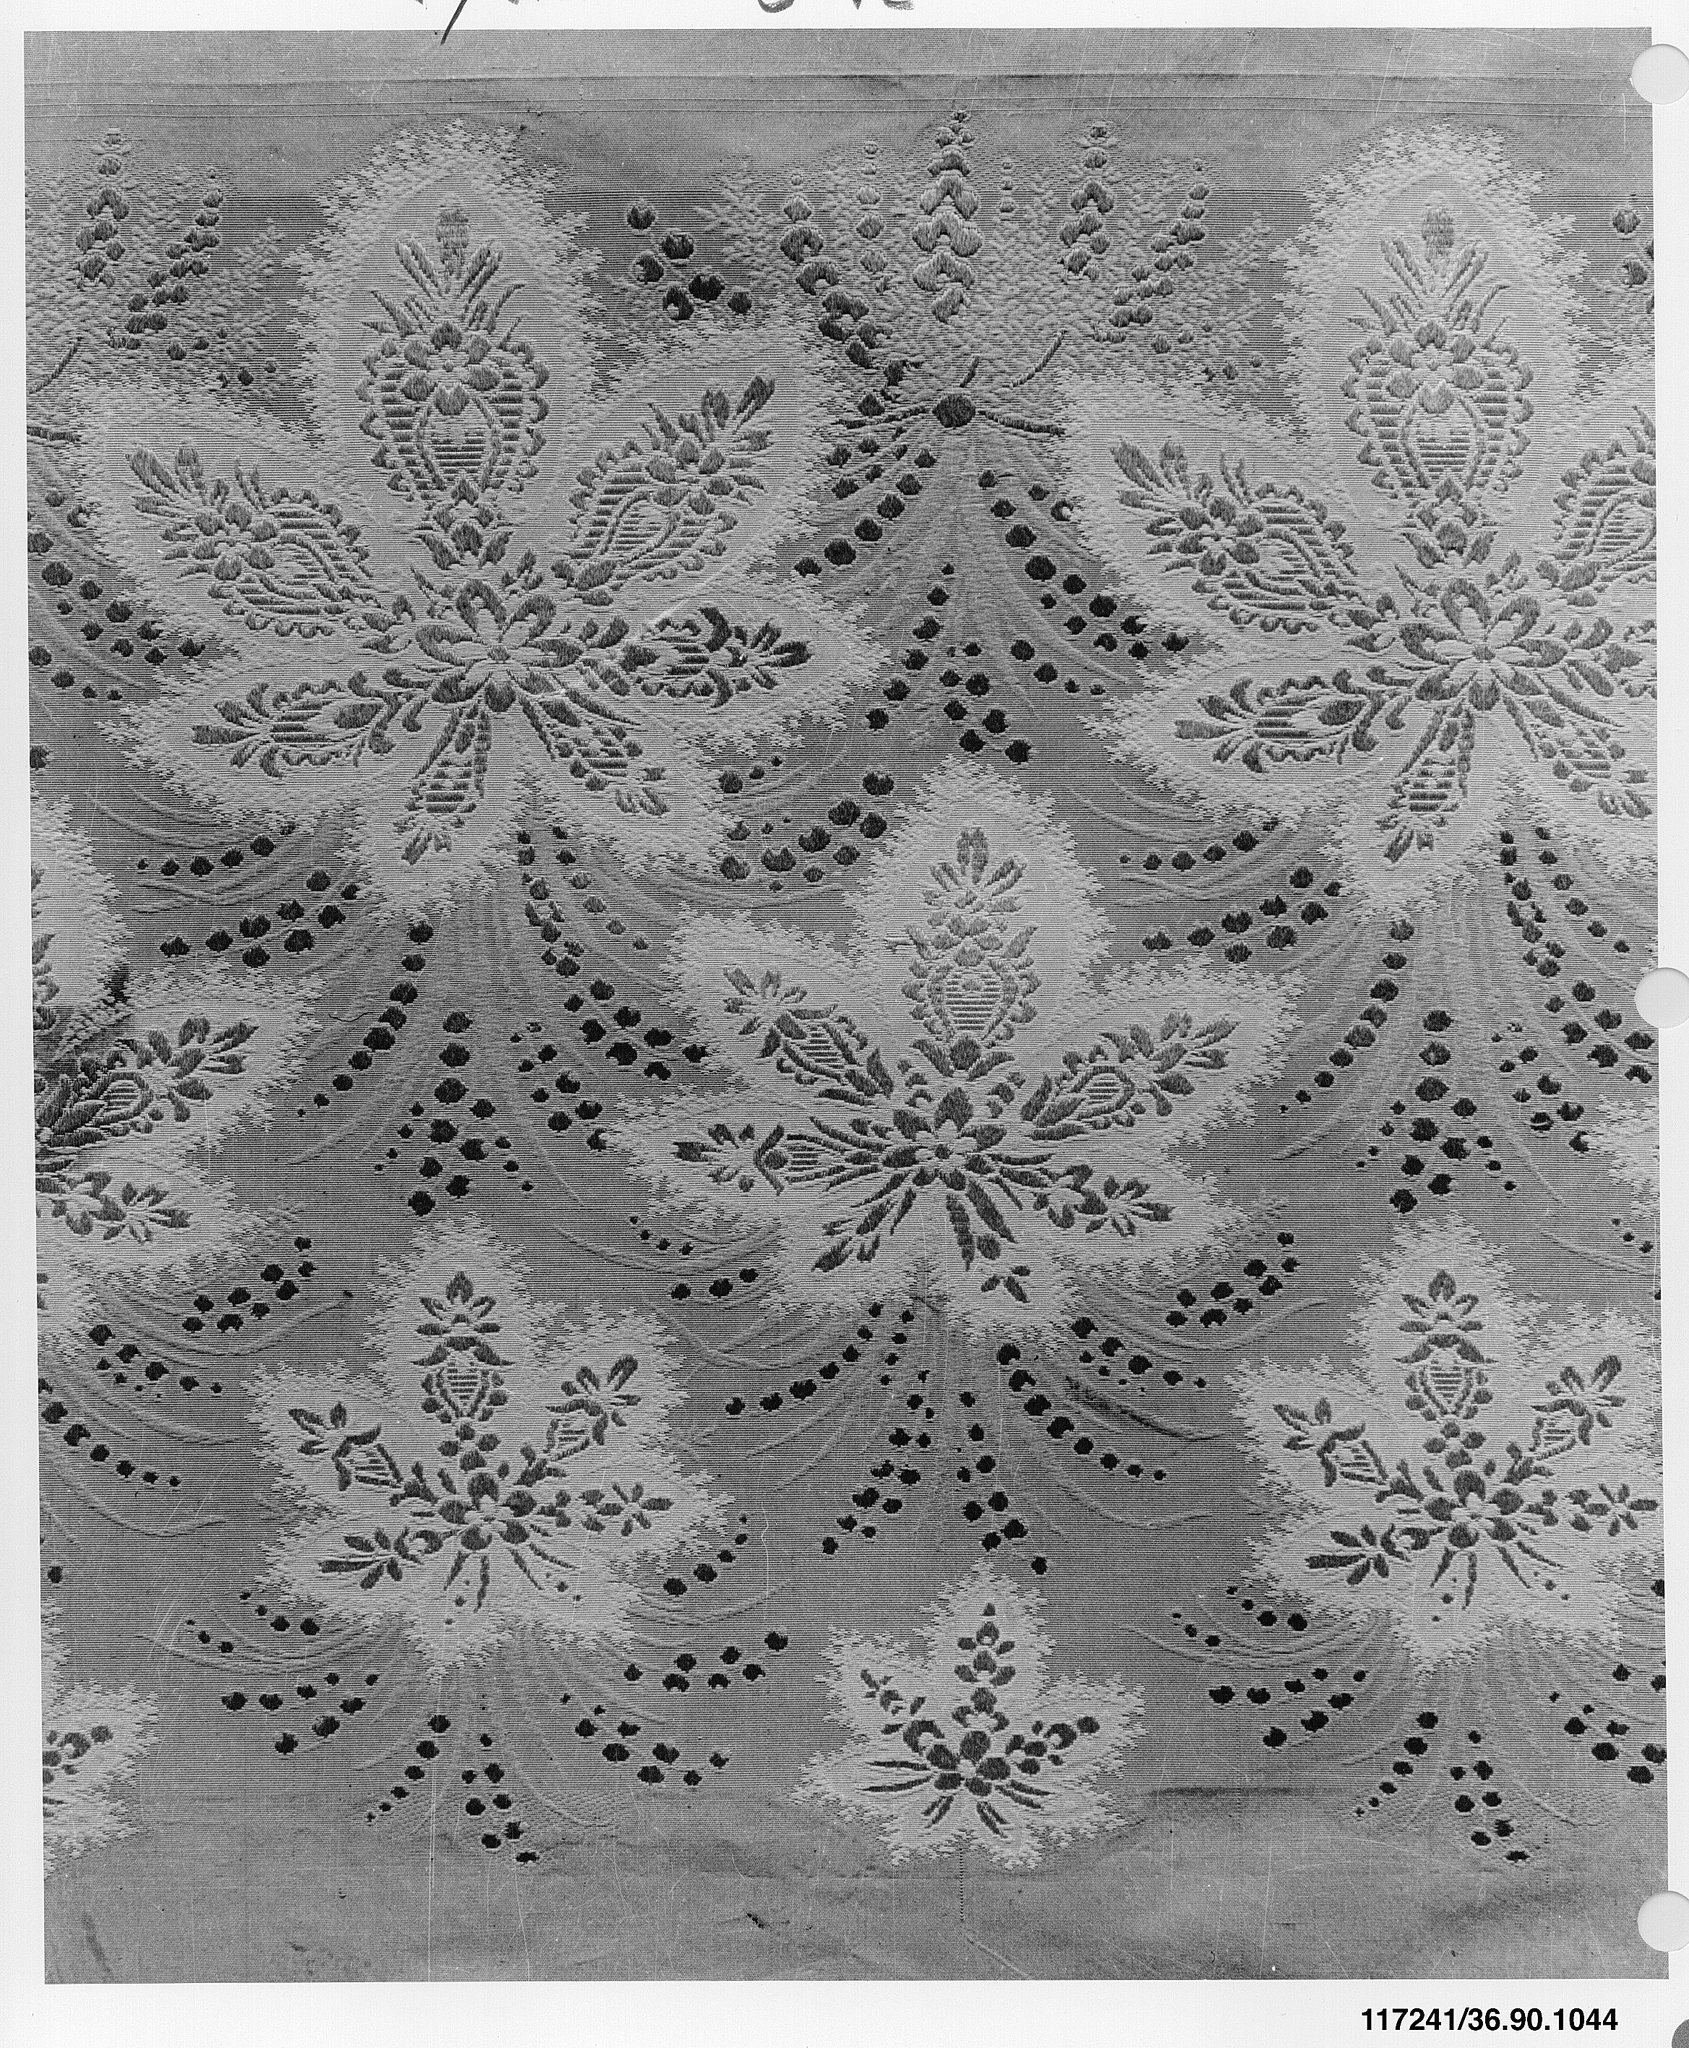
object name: piece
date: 1801-1900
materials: silk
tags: flowers,leaves